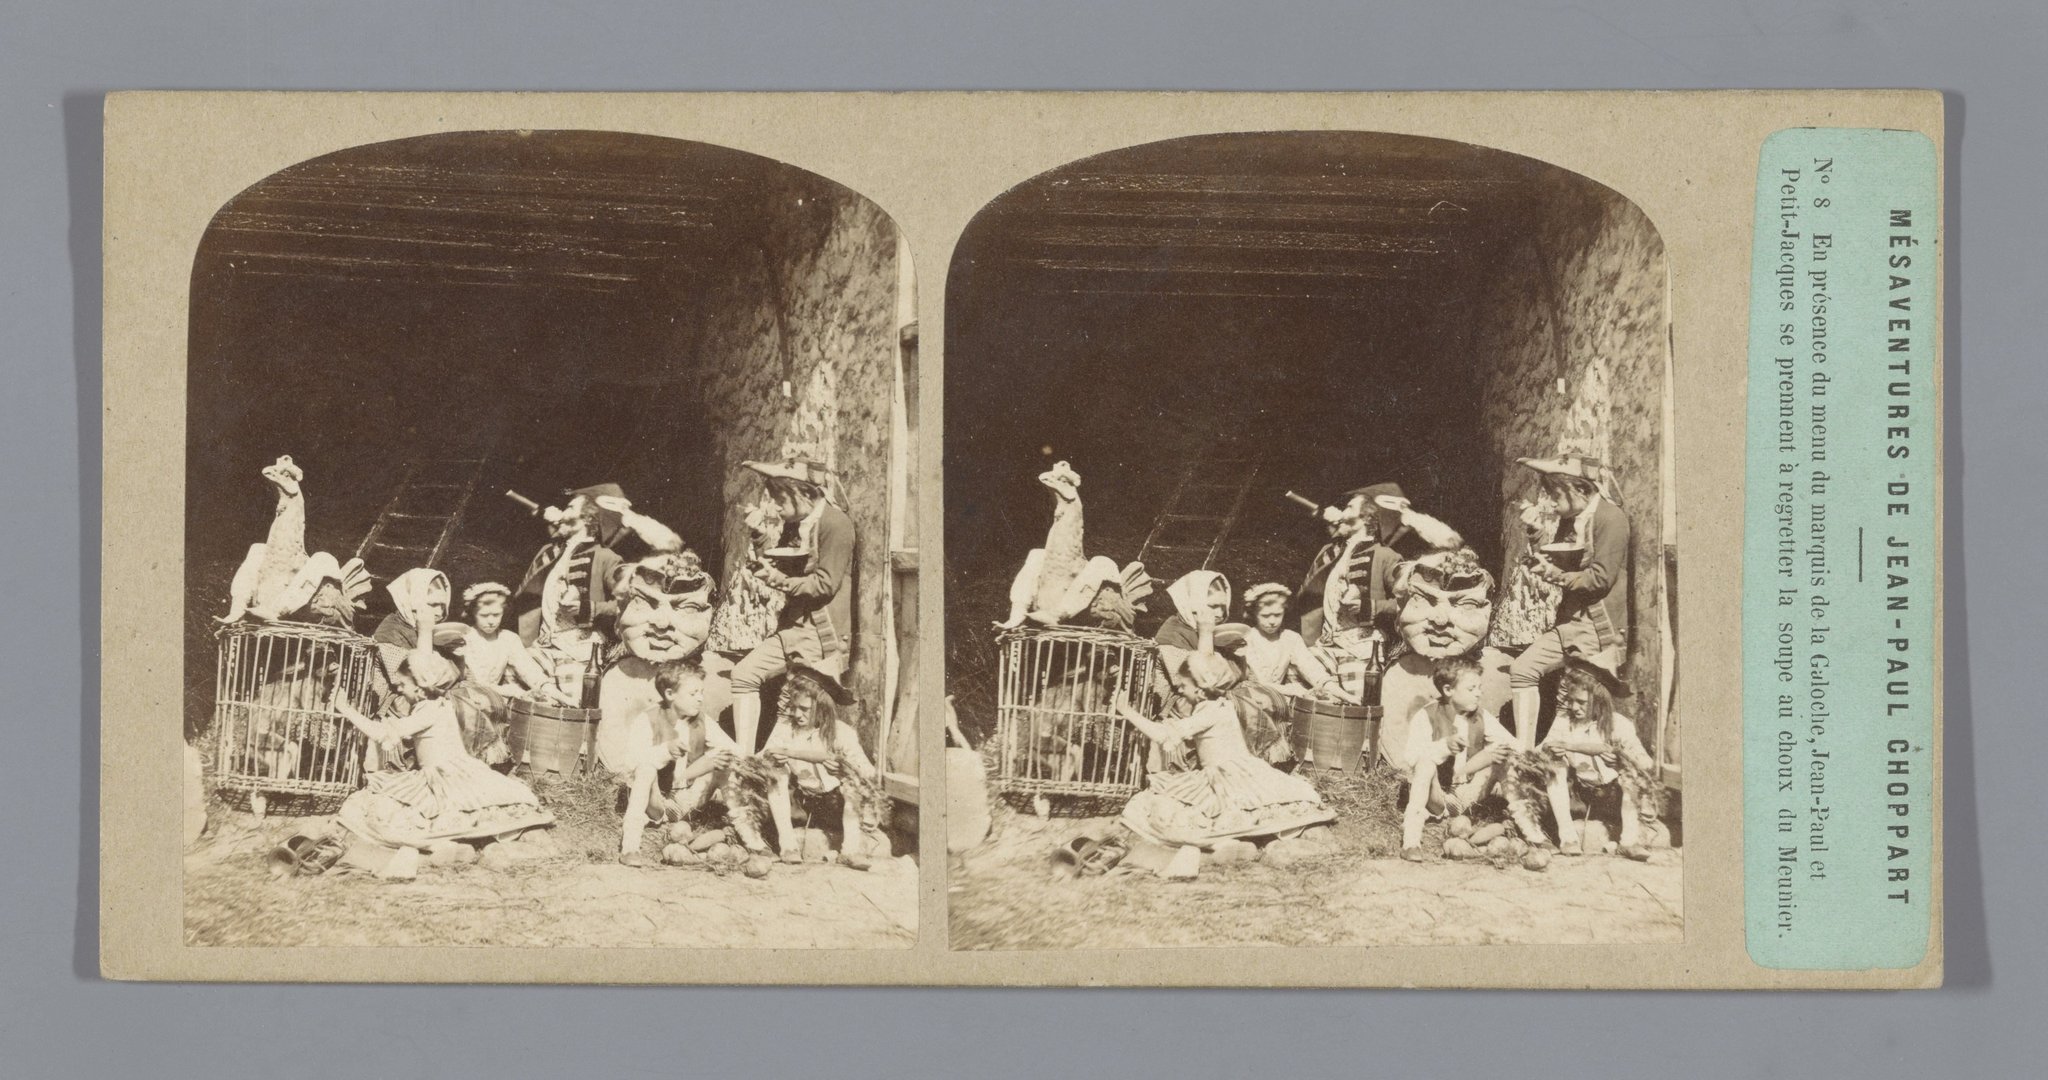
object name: stereograph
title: Mésaventures de Jean-Paul Choppart en présence du menu du marquis de la Galoche, Jean-Paul et Petit-Jacques se prennent à regretter la soupe au choux du meunier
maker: Anonymous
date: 1850-1880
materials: cardboard, photographic support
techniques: albumen print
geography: groningen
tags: set, scenery ~ stage, mask, europe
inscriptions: number: ‘No 8’, name: ‘Feldbrugge [...] Groningen’, inscription: ‘de 60’